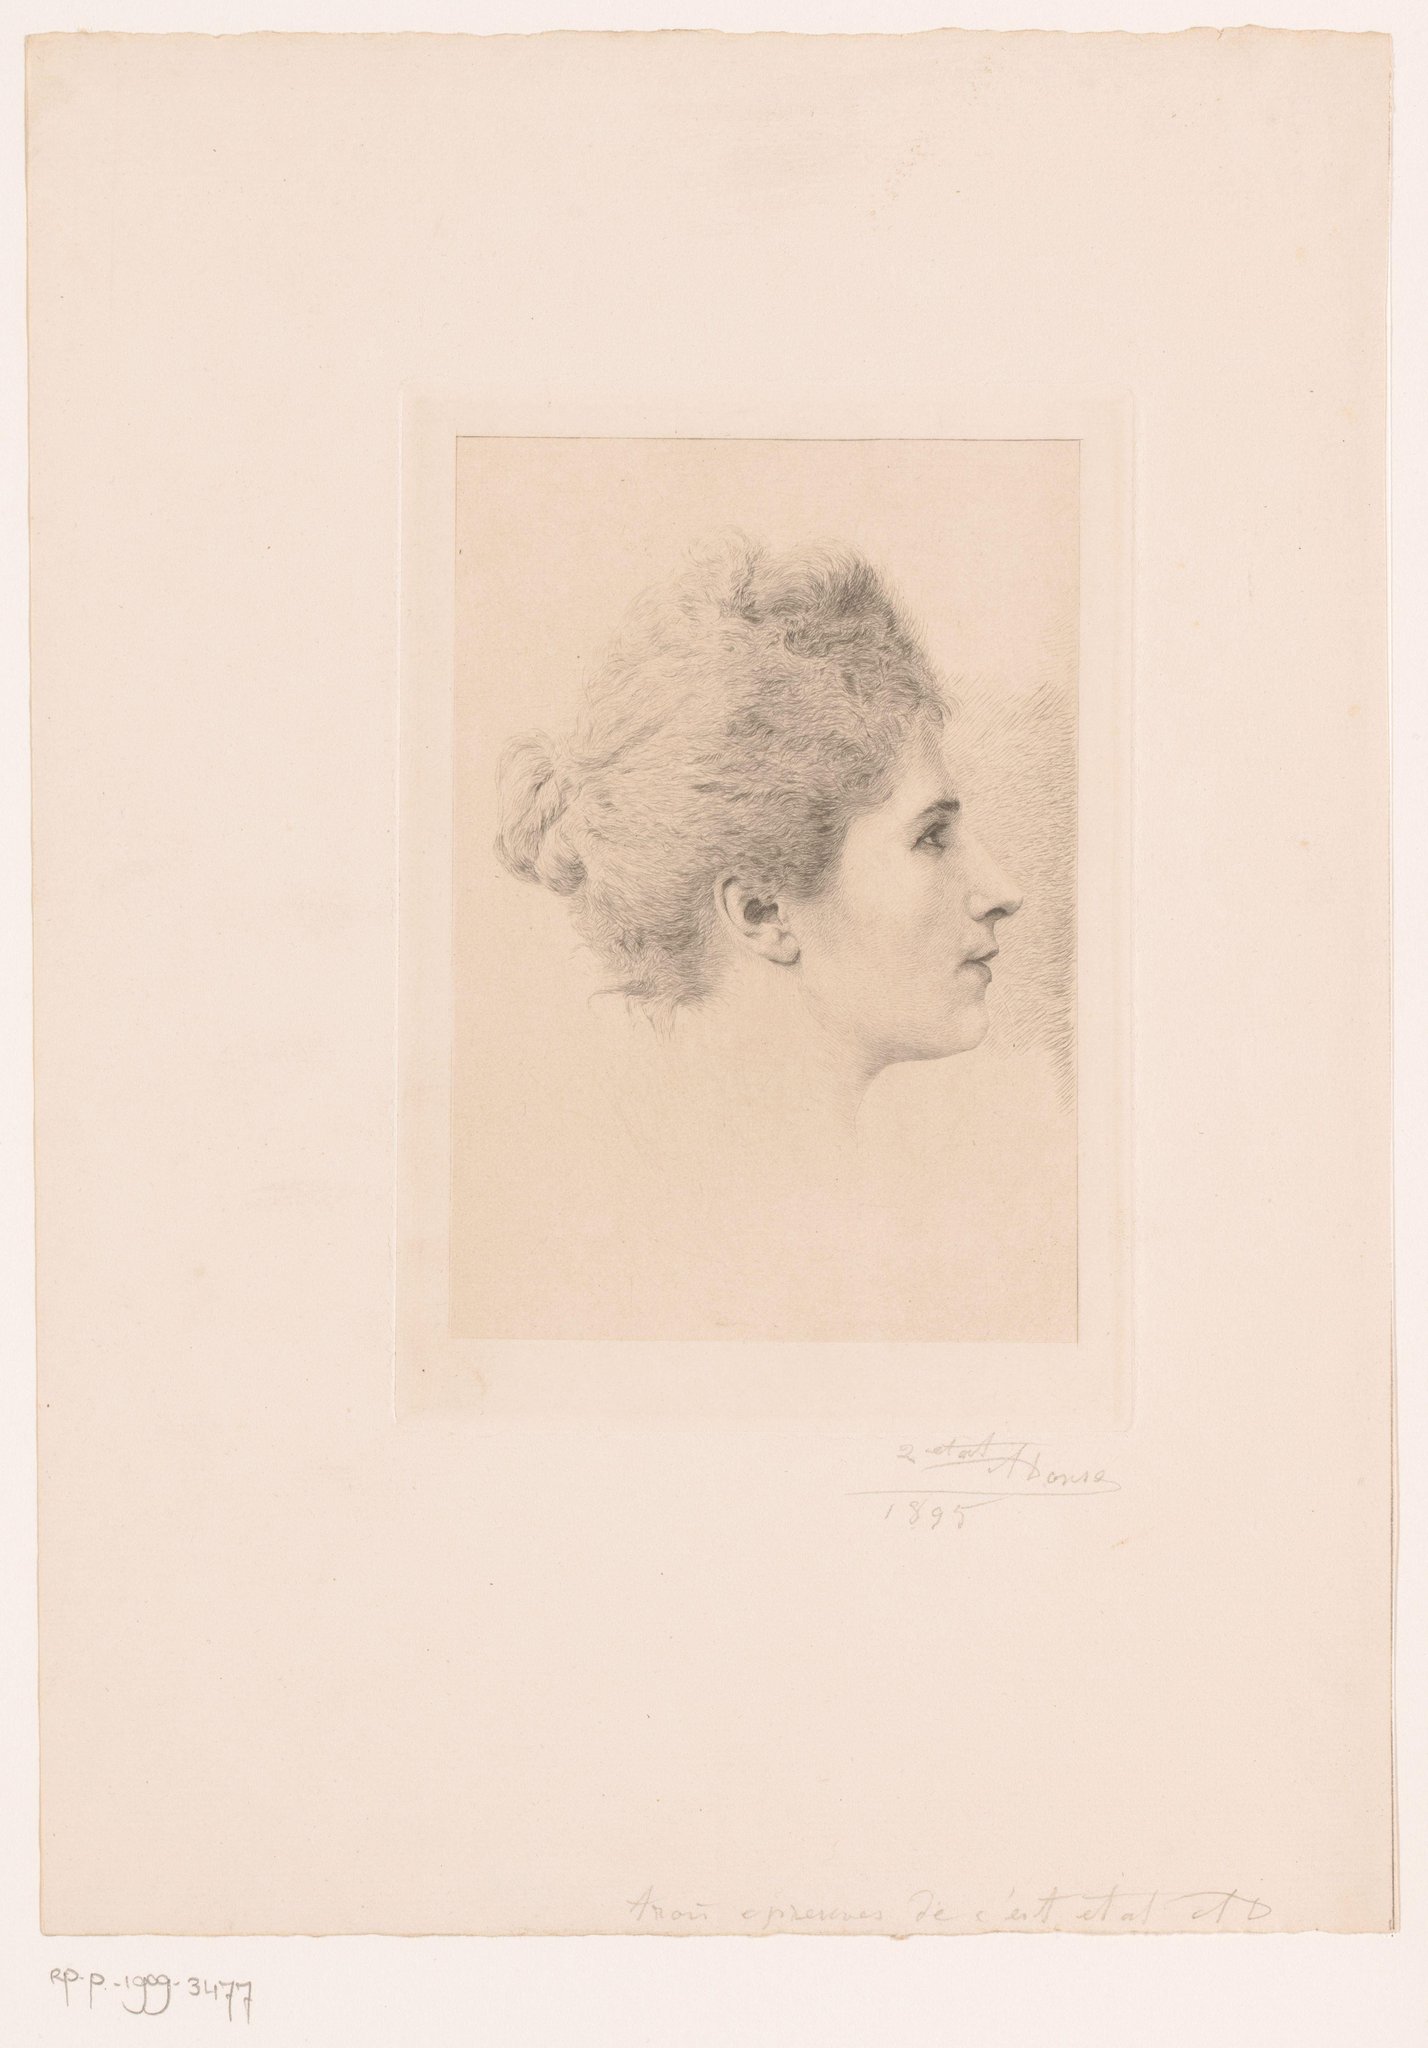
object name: print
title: Portret van Louise Danse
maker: auguste danse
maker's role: print maker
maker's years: 1829-1929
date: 1895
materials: paper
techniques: etching, intaglio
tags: brussels, painter, print maker, louise danse, portrait, self-portrait of artist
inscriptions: watermark: ‘MBM’, annotation: ‘2 etat; trois epreuves de c'est etat’, collector's mark: Lugt 2228